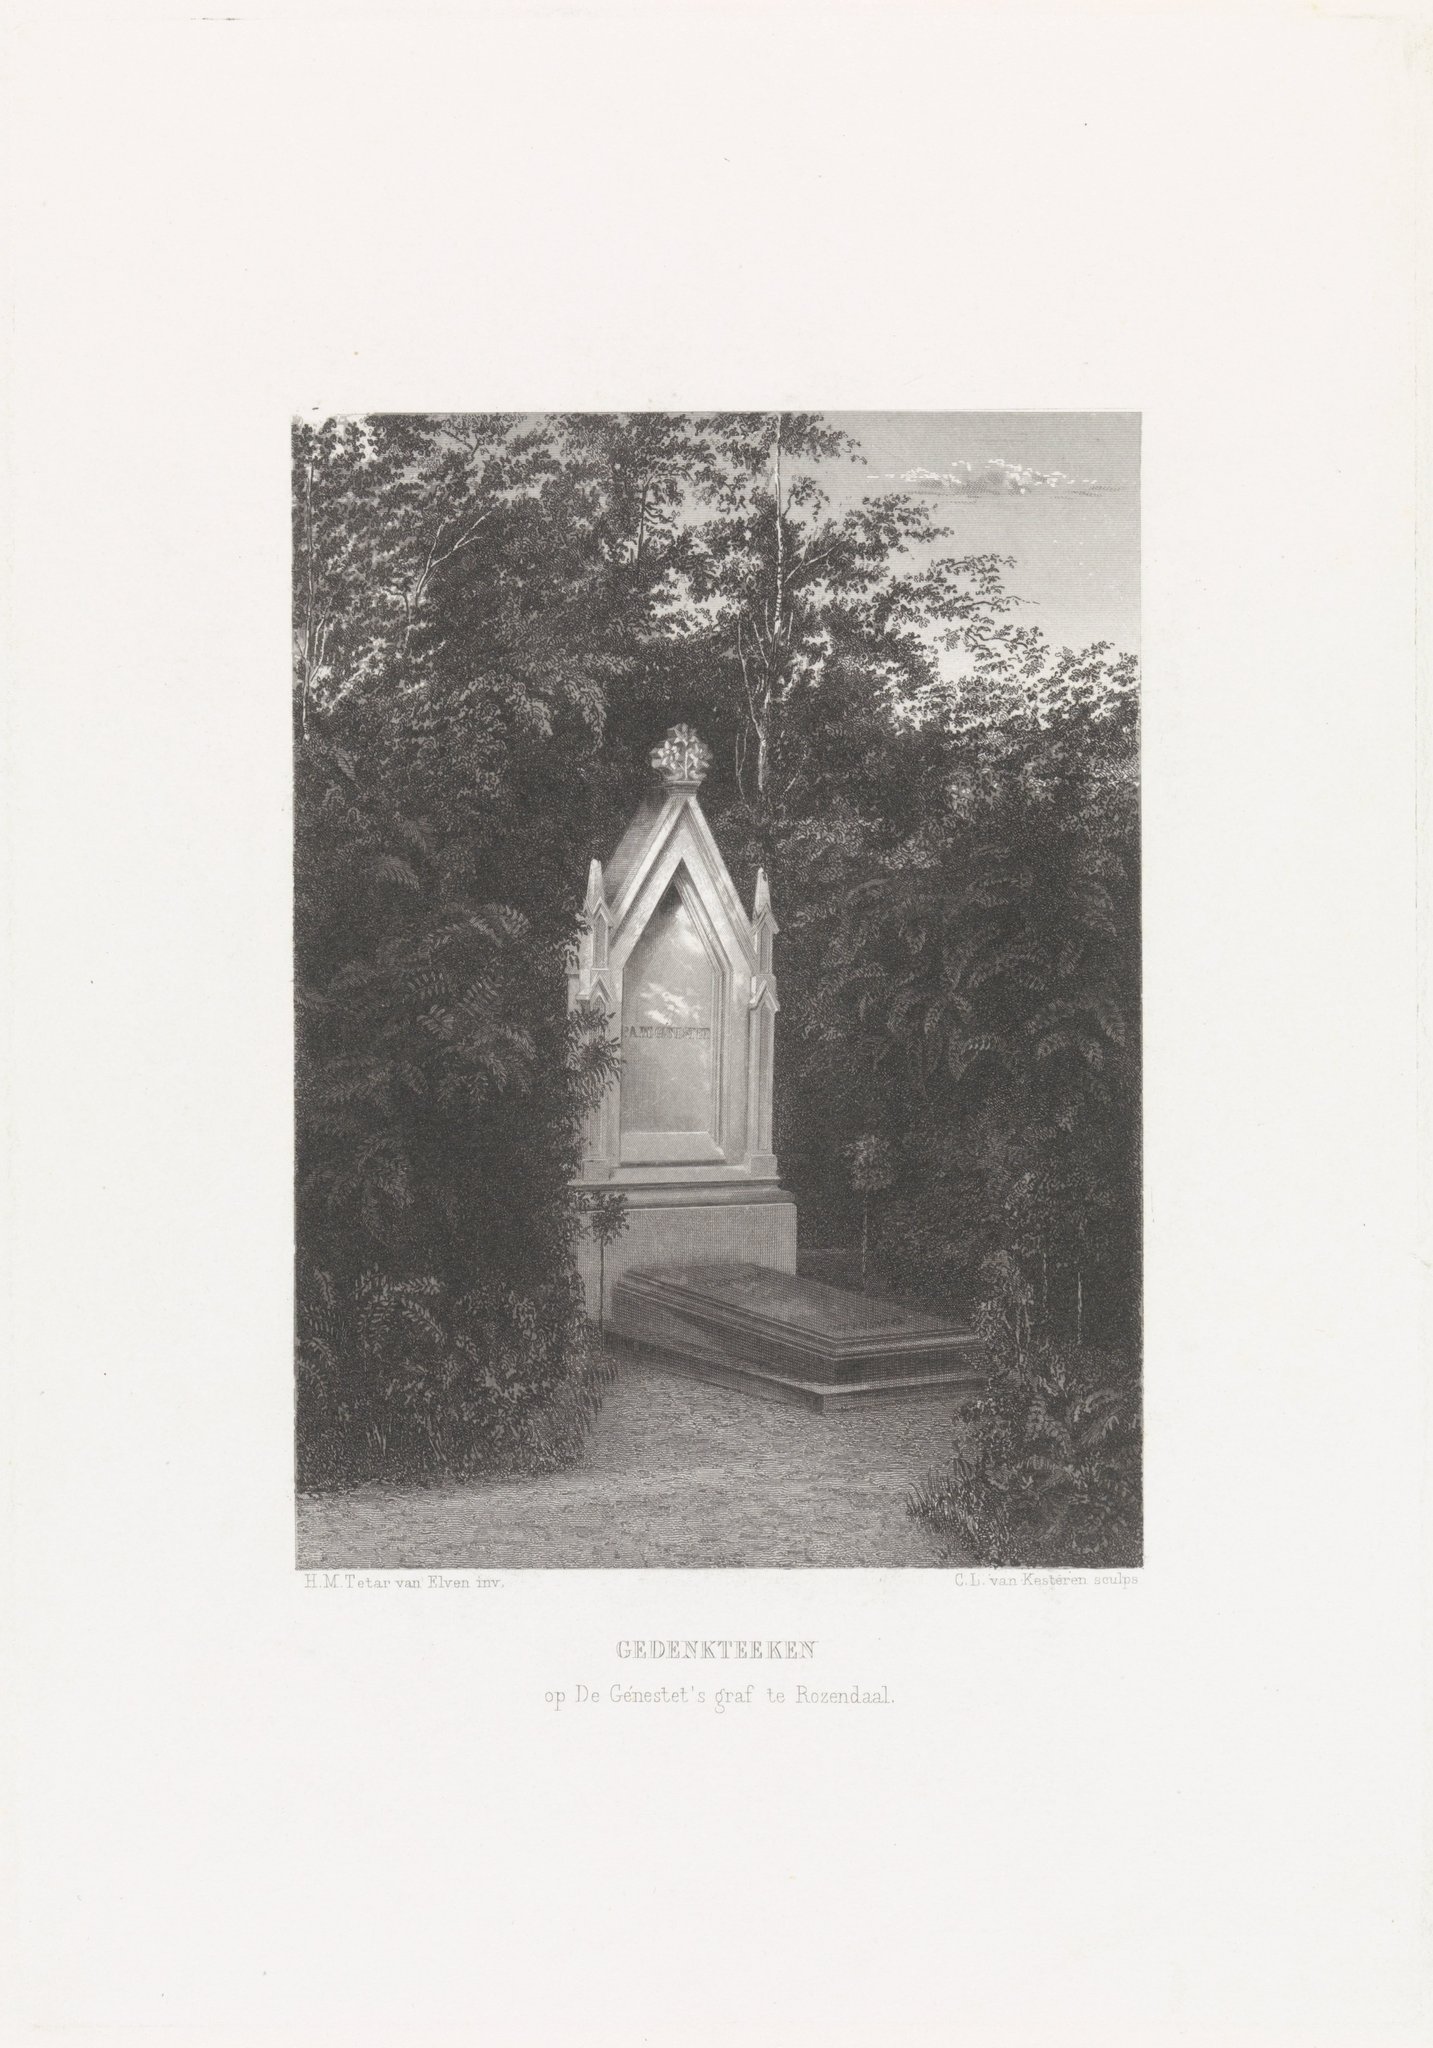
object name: print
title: Graf van Petrus Augustus de Génestet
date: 1861-1866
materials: paper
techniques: engraving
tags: amsterdam, petrus augustus de génestet, grave, tomb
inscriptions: collector's mark: Lugt 2228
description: Het graf van de remonstrantse predikant en dichter Petrus Augustus de Génestet is omgeven door een diversiteit aan planten en zijn grafsteen wordt verlicht door het zonlicht.